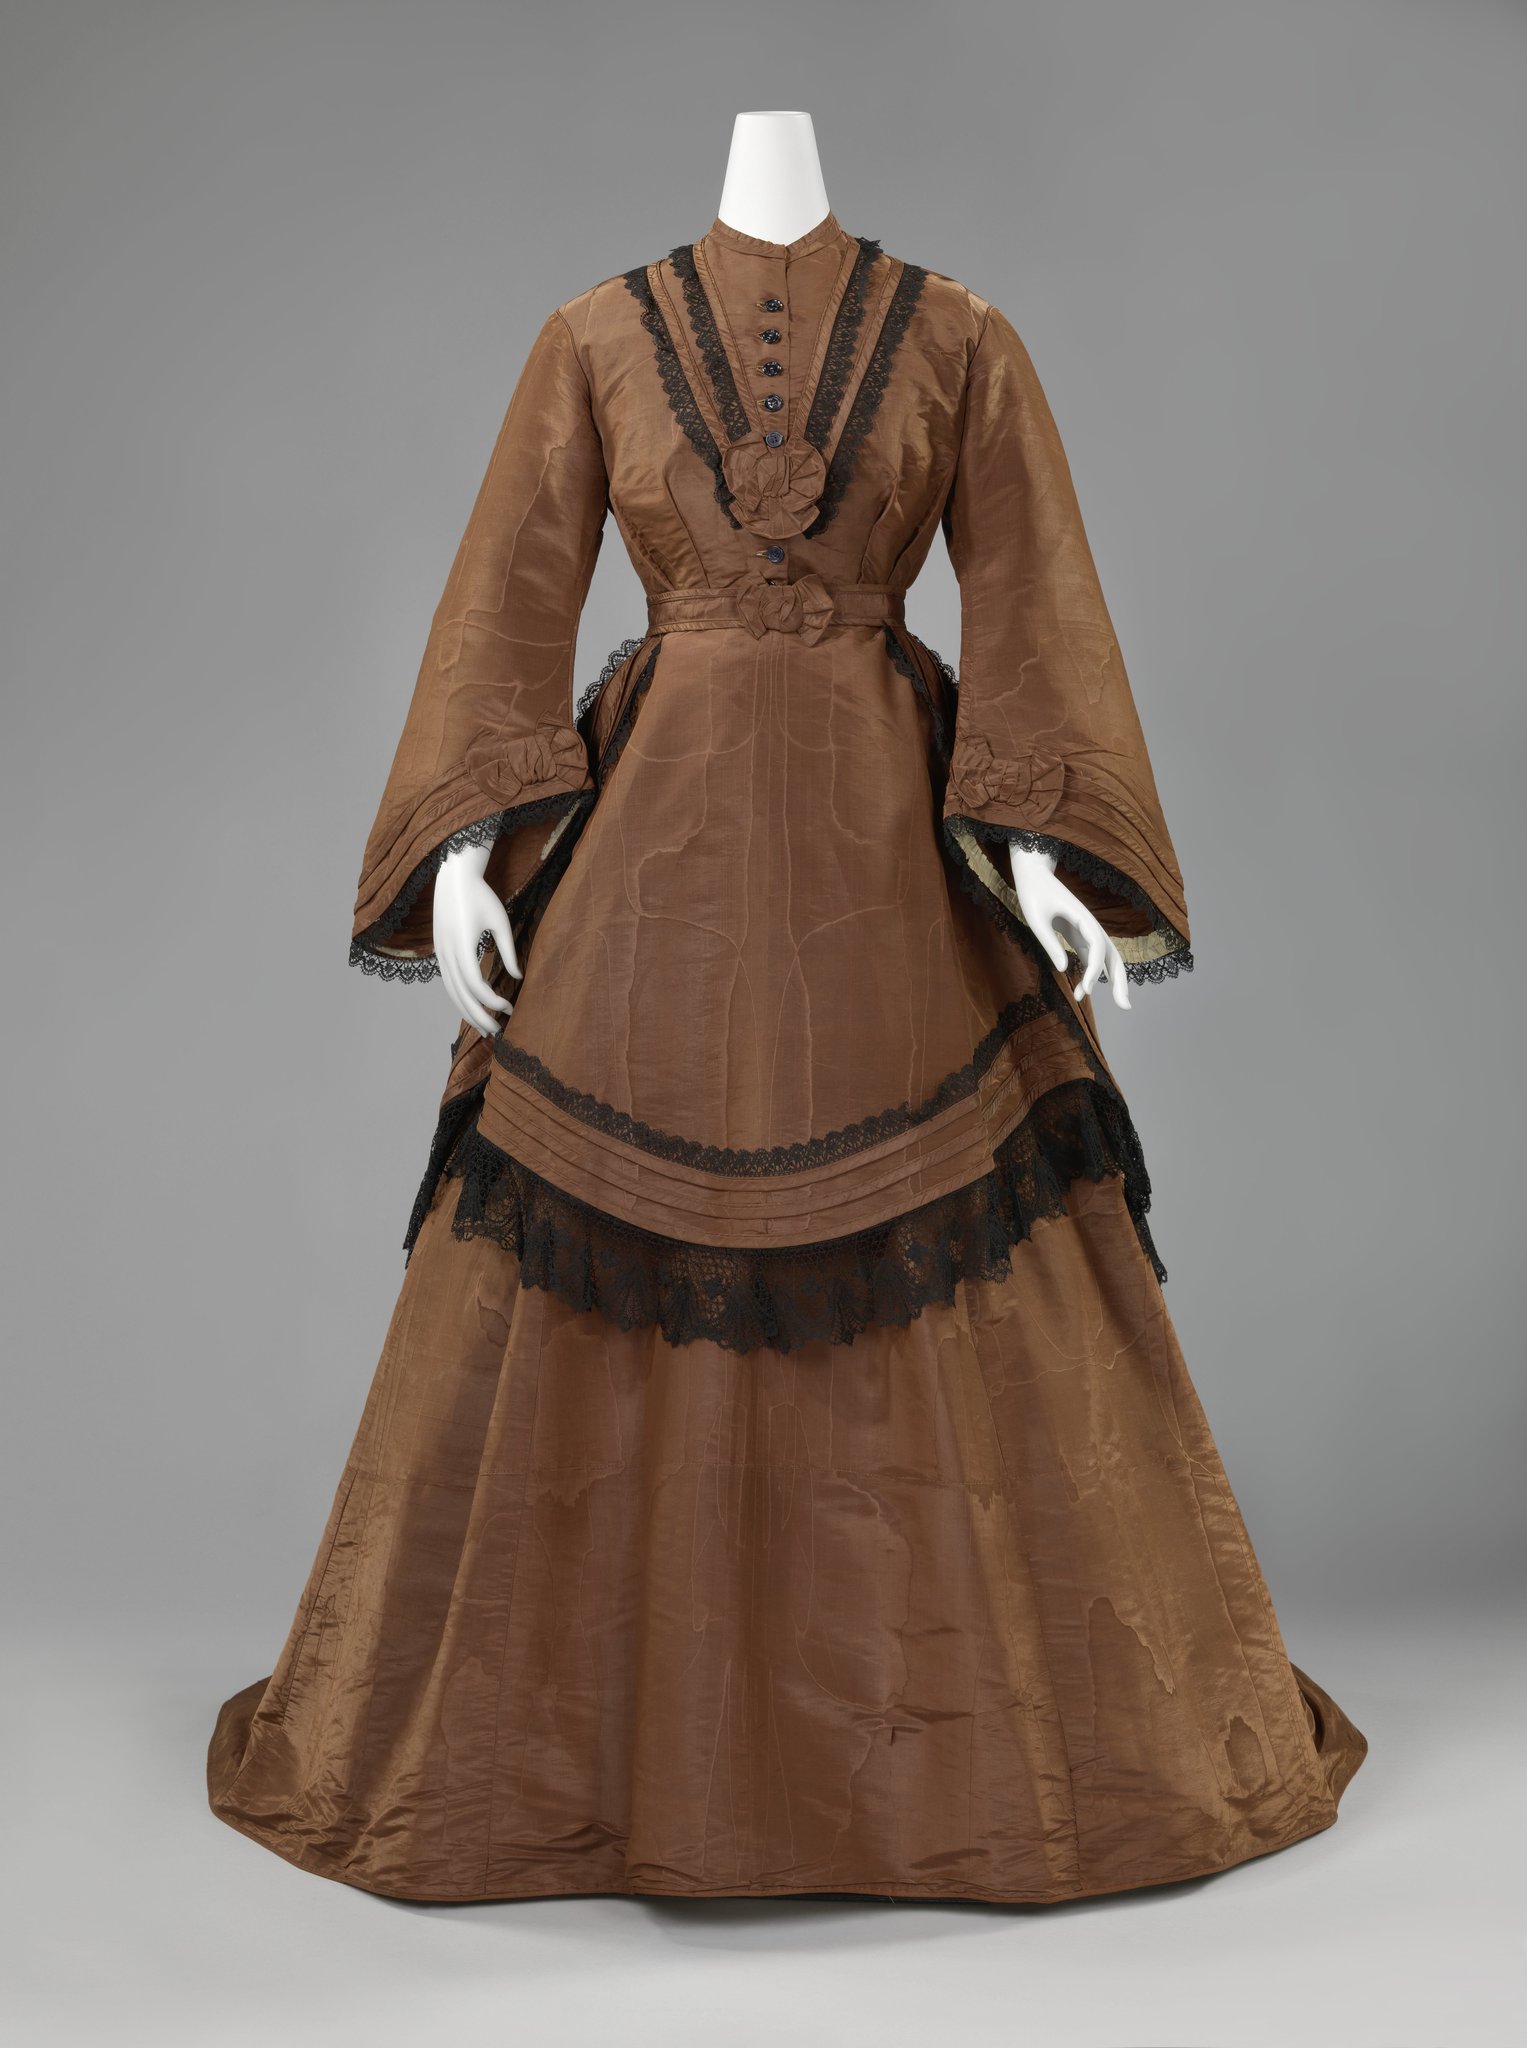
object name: main garment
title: Lijf met hele korte mouw, halverwege versierd met opgestikte rand, en laag op de schouders vallende hals, van bruine moirézijde, gevoerd met bruin geglansd katoen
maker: Anonymous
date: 1868-1872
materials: silk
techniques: moire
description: Lijf met hele korte mouw, halverwege versierd met opgestikte rand, en laag op de schouders vallende hals, van bruine moirézijde, gevoerd met bruin geglansd katoen.